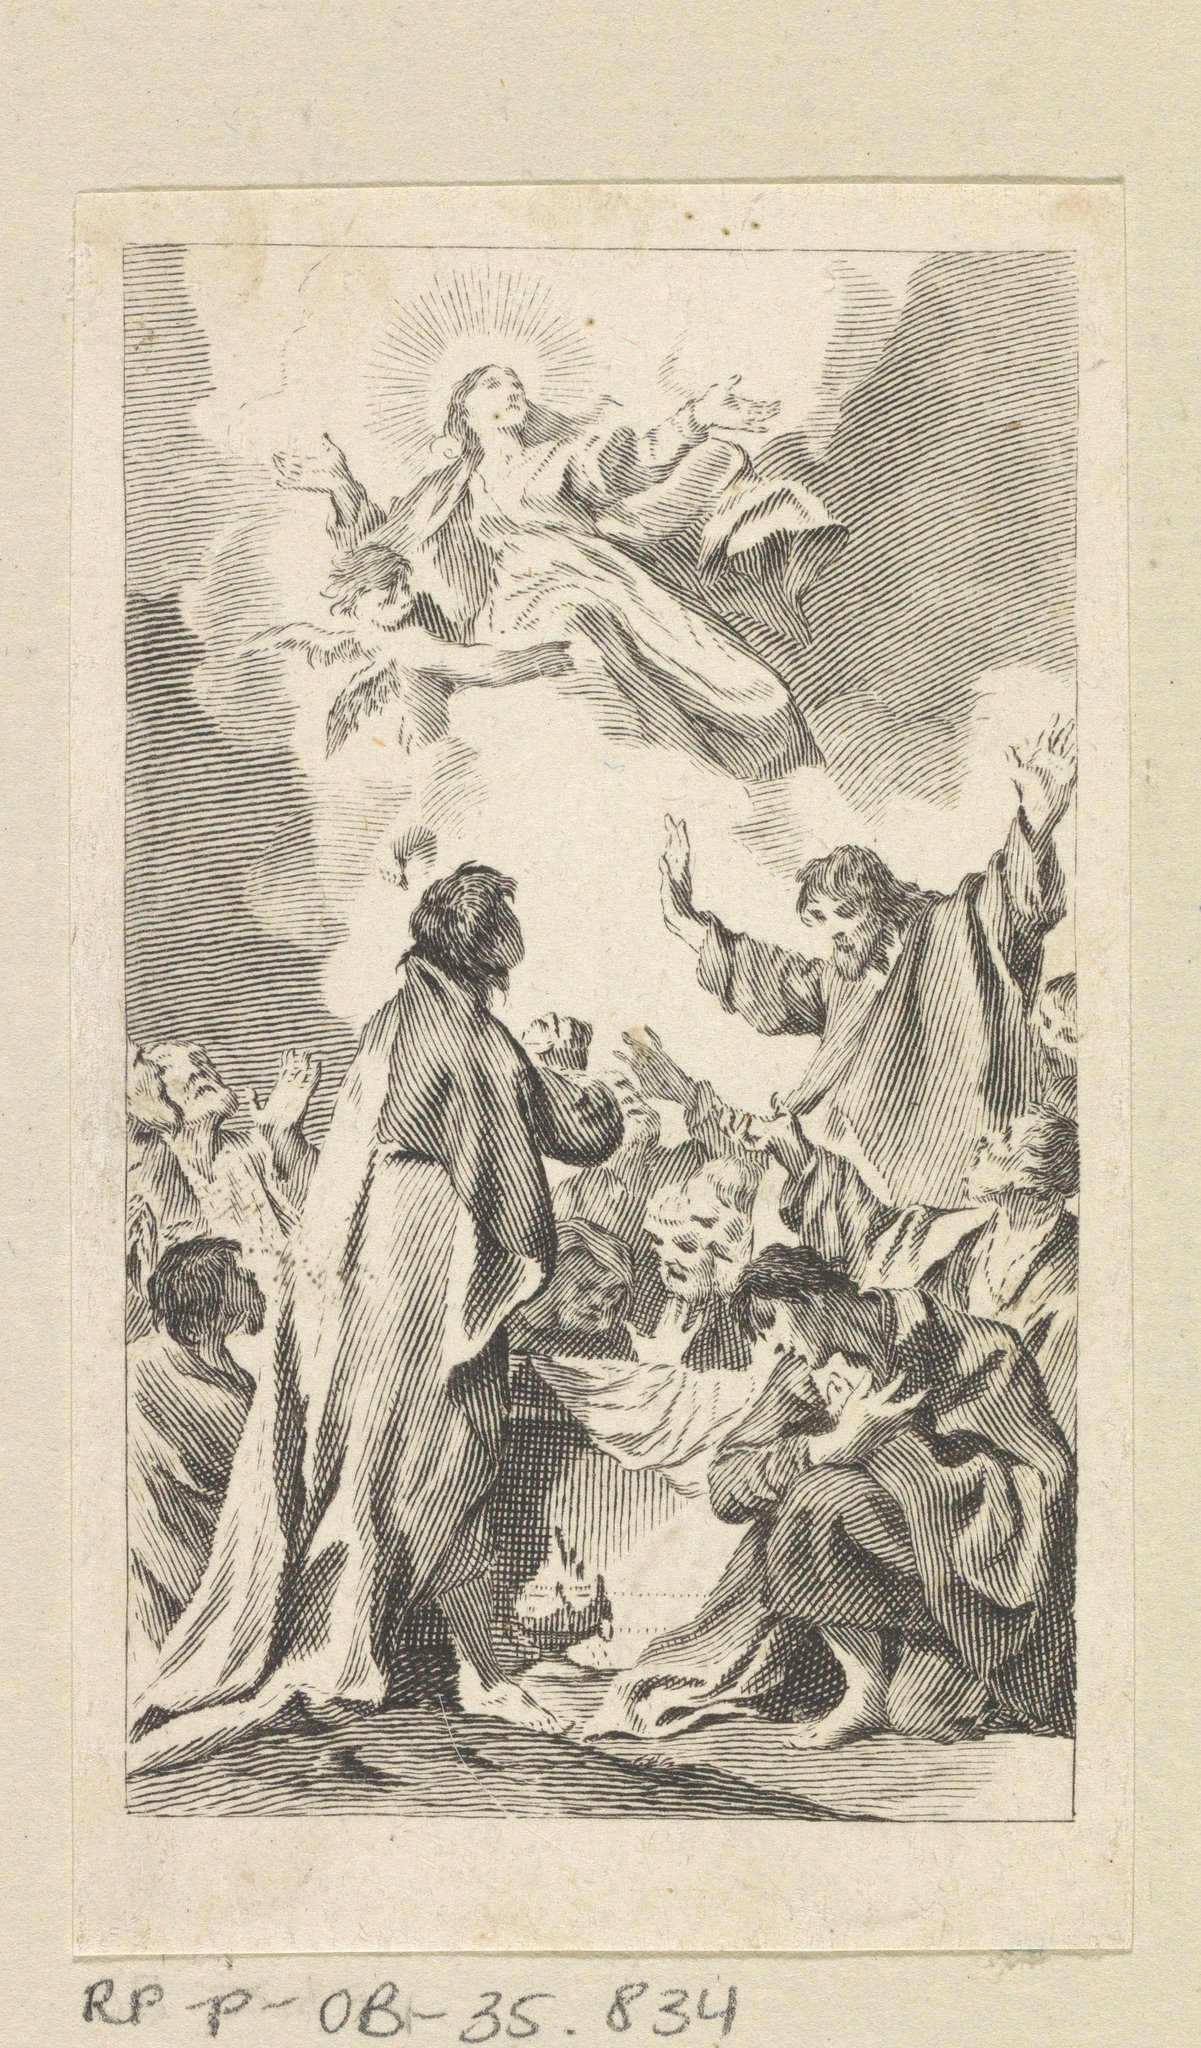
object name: print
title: Beatae Mariae virginis officium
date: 1740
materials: paper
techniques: engraving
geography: venice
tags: the assumption of mary ('assumptio corporis'): she is borne into heaven by angels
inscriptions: collector's mark: Lugt 240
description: Prent uit een reeks van 16 prenten plus een titelprent.